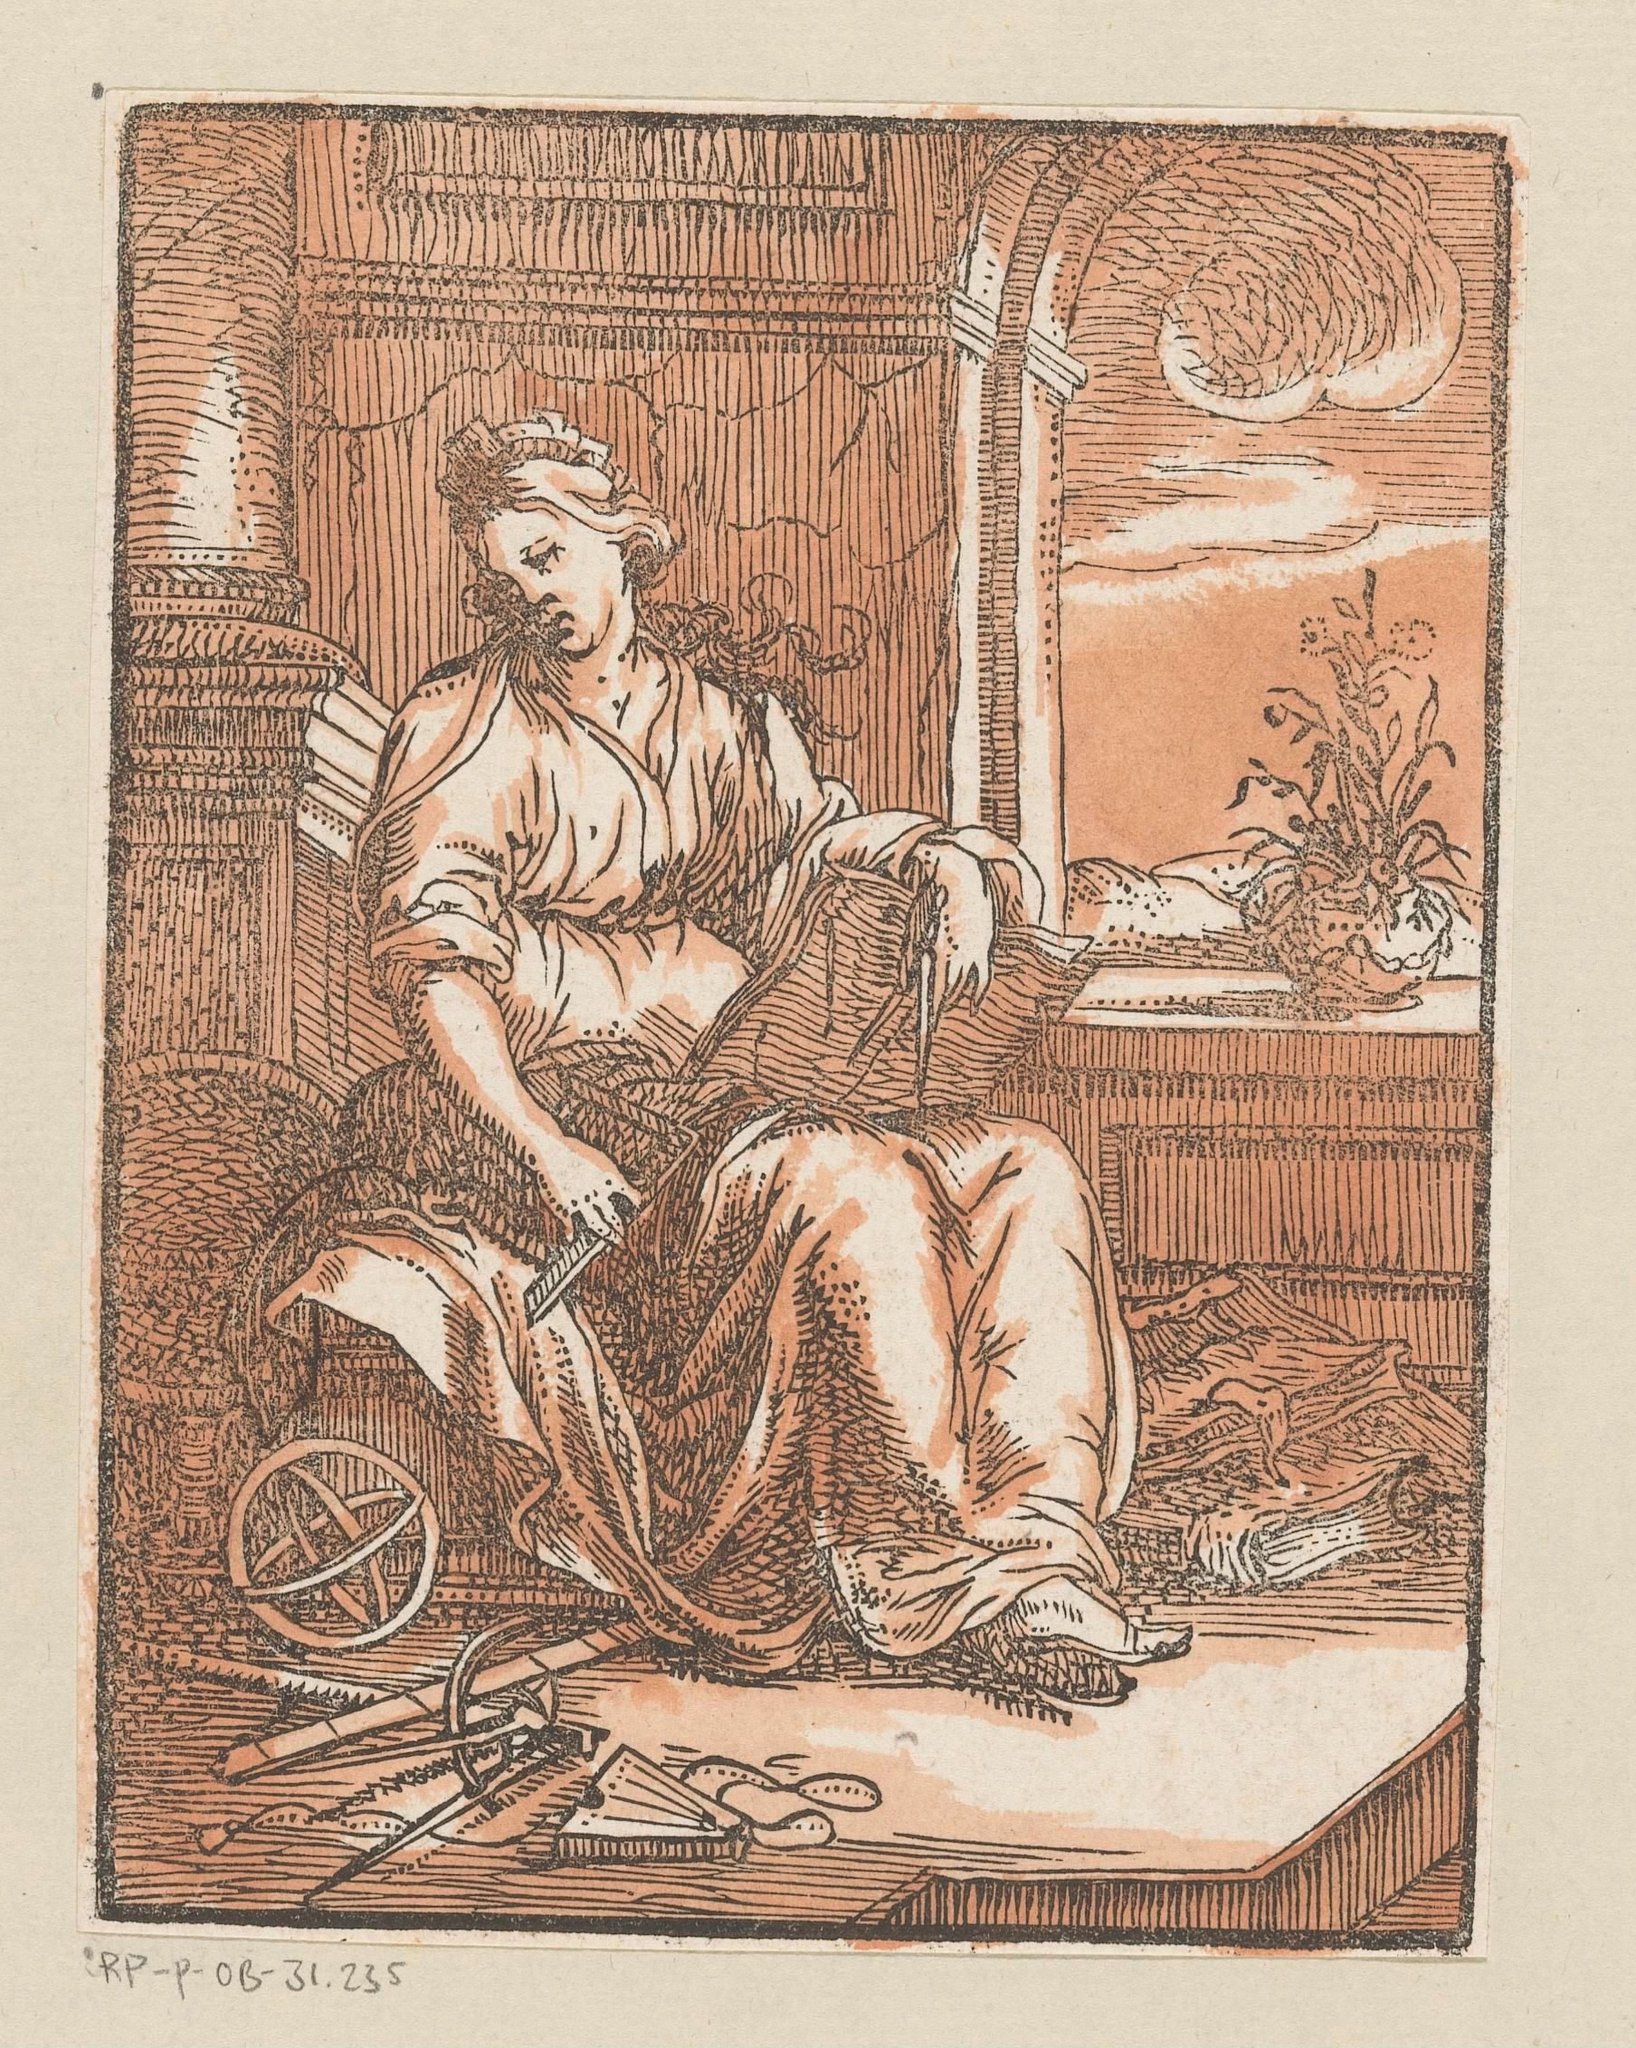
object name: print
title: Allegorie op de geometrie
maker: Anonymous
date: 1500-1599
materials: paper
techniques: woodcut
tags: city-crown, mural crown, measuring-instruments, planimetry, geometry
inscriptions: collector's mark: Lugt 240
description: Een zittende vrouw met een muurkroon op het hoofd en meetinstrumenten in de hand, mogelijk een allegorie op de geometrie.